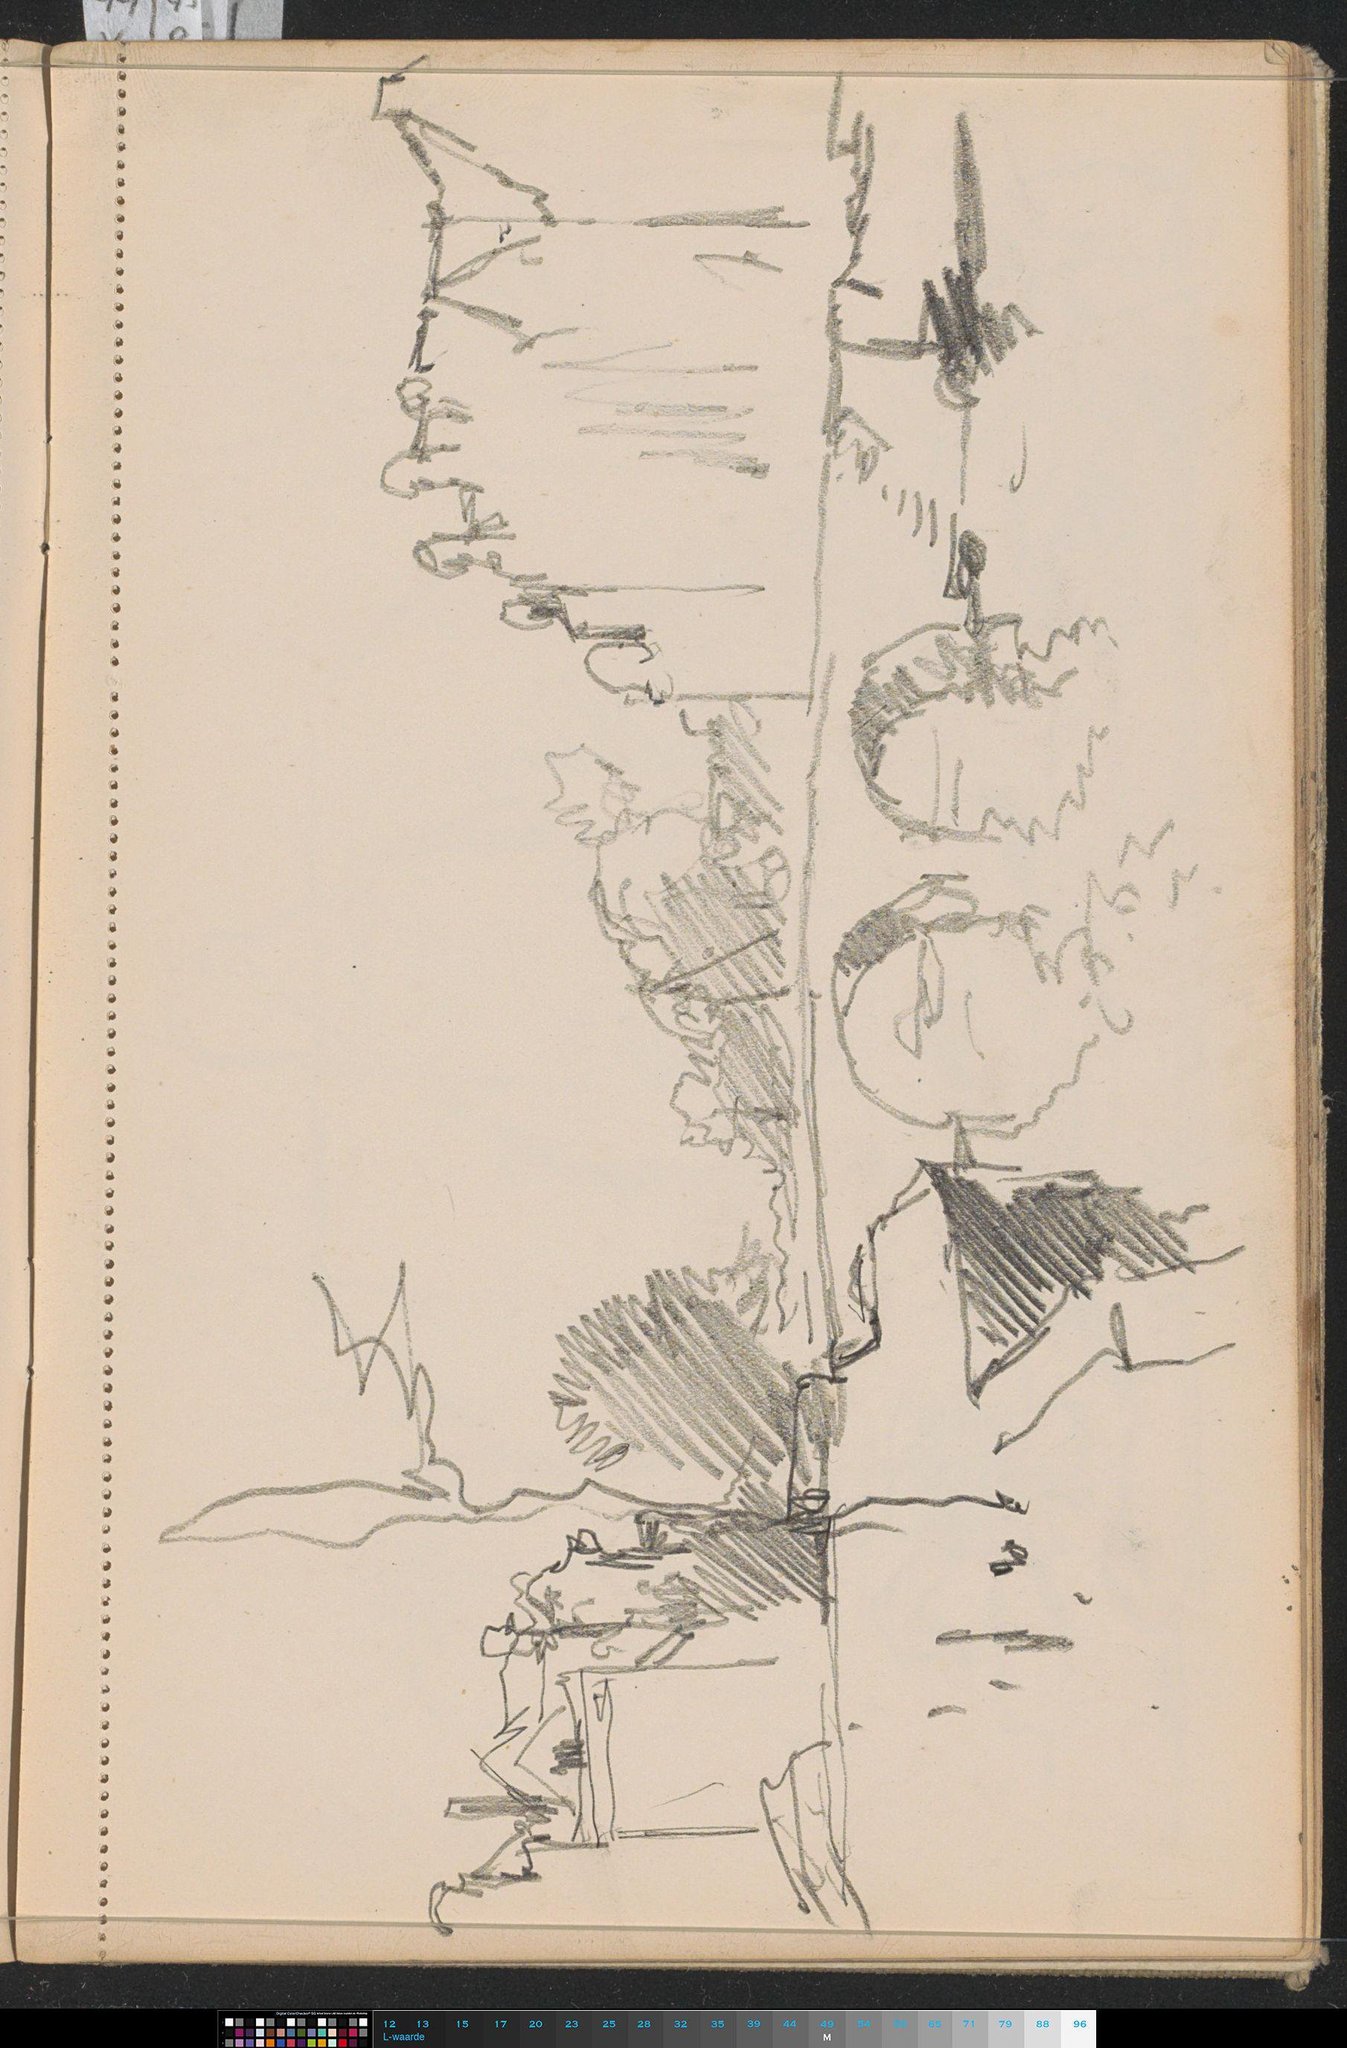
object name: sketchbook leaf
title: Brug met twee bogen over een gracht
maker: cornelis vreedenburgh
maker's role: draughtsman, print maker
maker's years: 1880-1946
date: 1890-1946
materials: paper, pencil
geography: amsterdam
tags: bridge in city across river, canal, etc.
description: Blad 40 recto uit een schetsboek met 59 bladen.